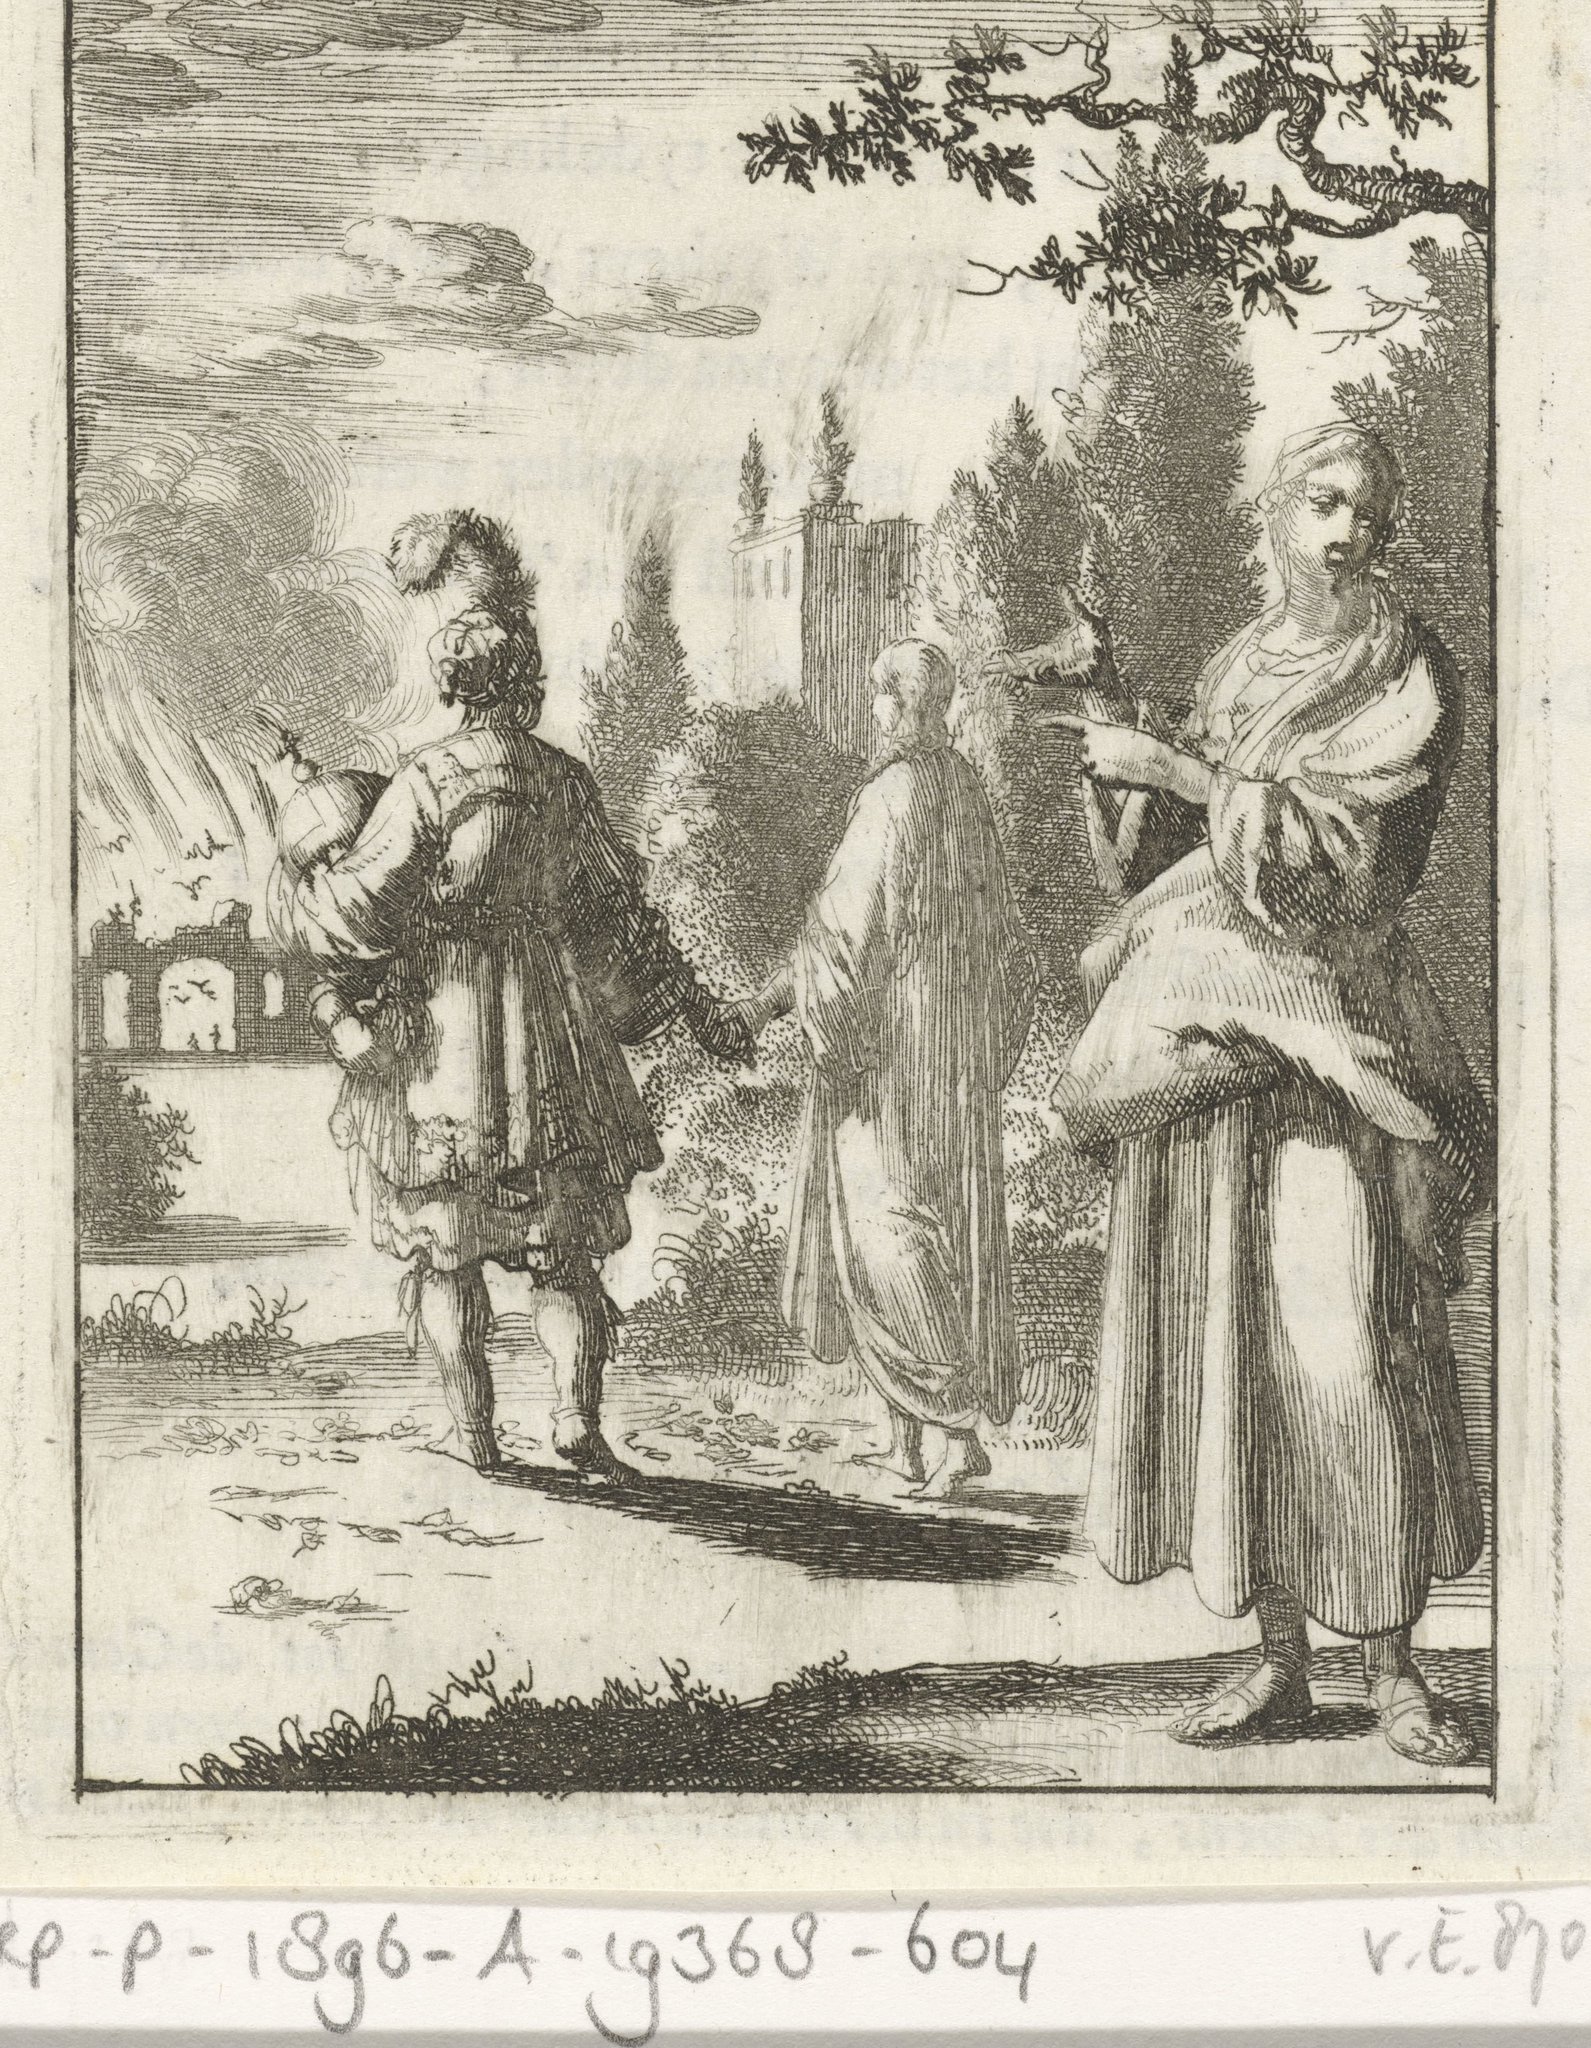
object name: book illustration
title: 't Is al geen Goudt, wat' er blinckt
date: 1687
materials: paper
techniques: etching, letterpress printing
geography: amsterdam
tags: spirit (or soul) versus body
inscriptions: collector's mark: Lugt 2228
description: Illustratie uit: Luyken, Jan. Voncken der liefde Jesu, van het godtbegerende zielenvier. Amsterdam: Pieter Arentsz (II), 1687, p. 146.